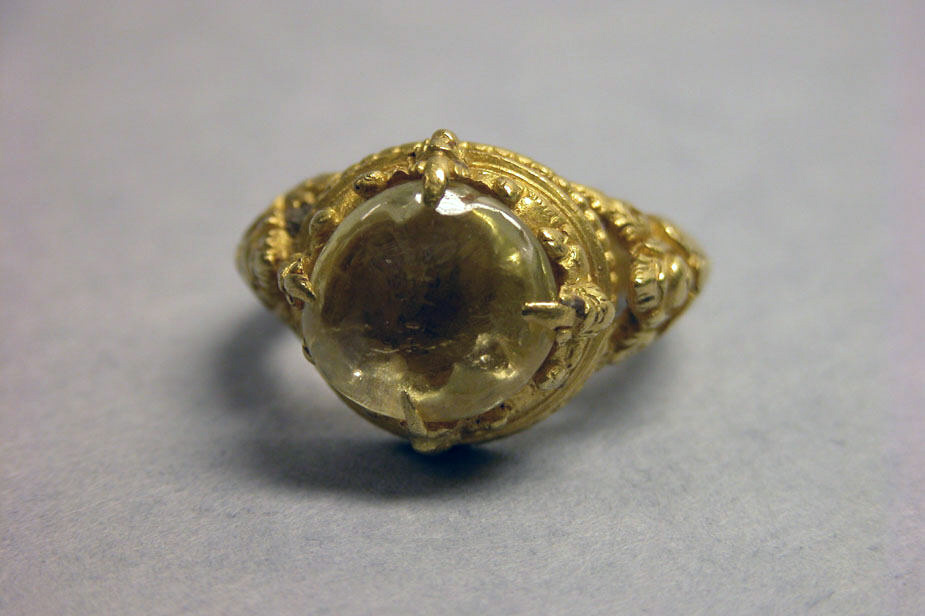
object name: ring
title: Ring with Yellow Stone and Ornamented with Foliate Forms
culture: indonesian, javanese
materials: gold, stone